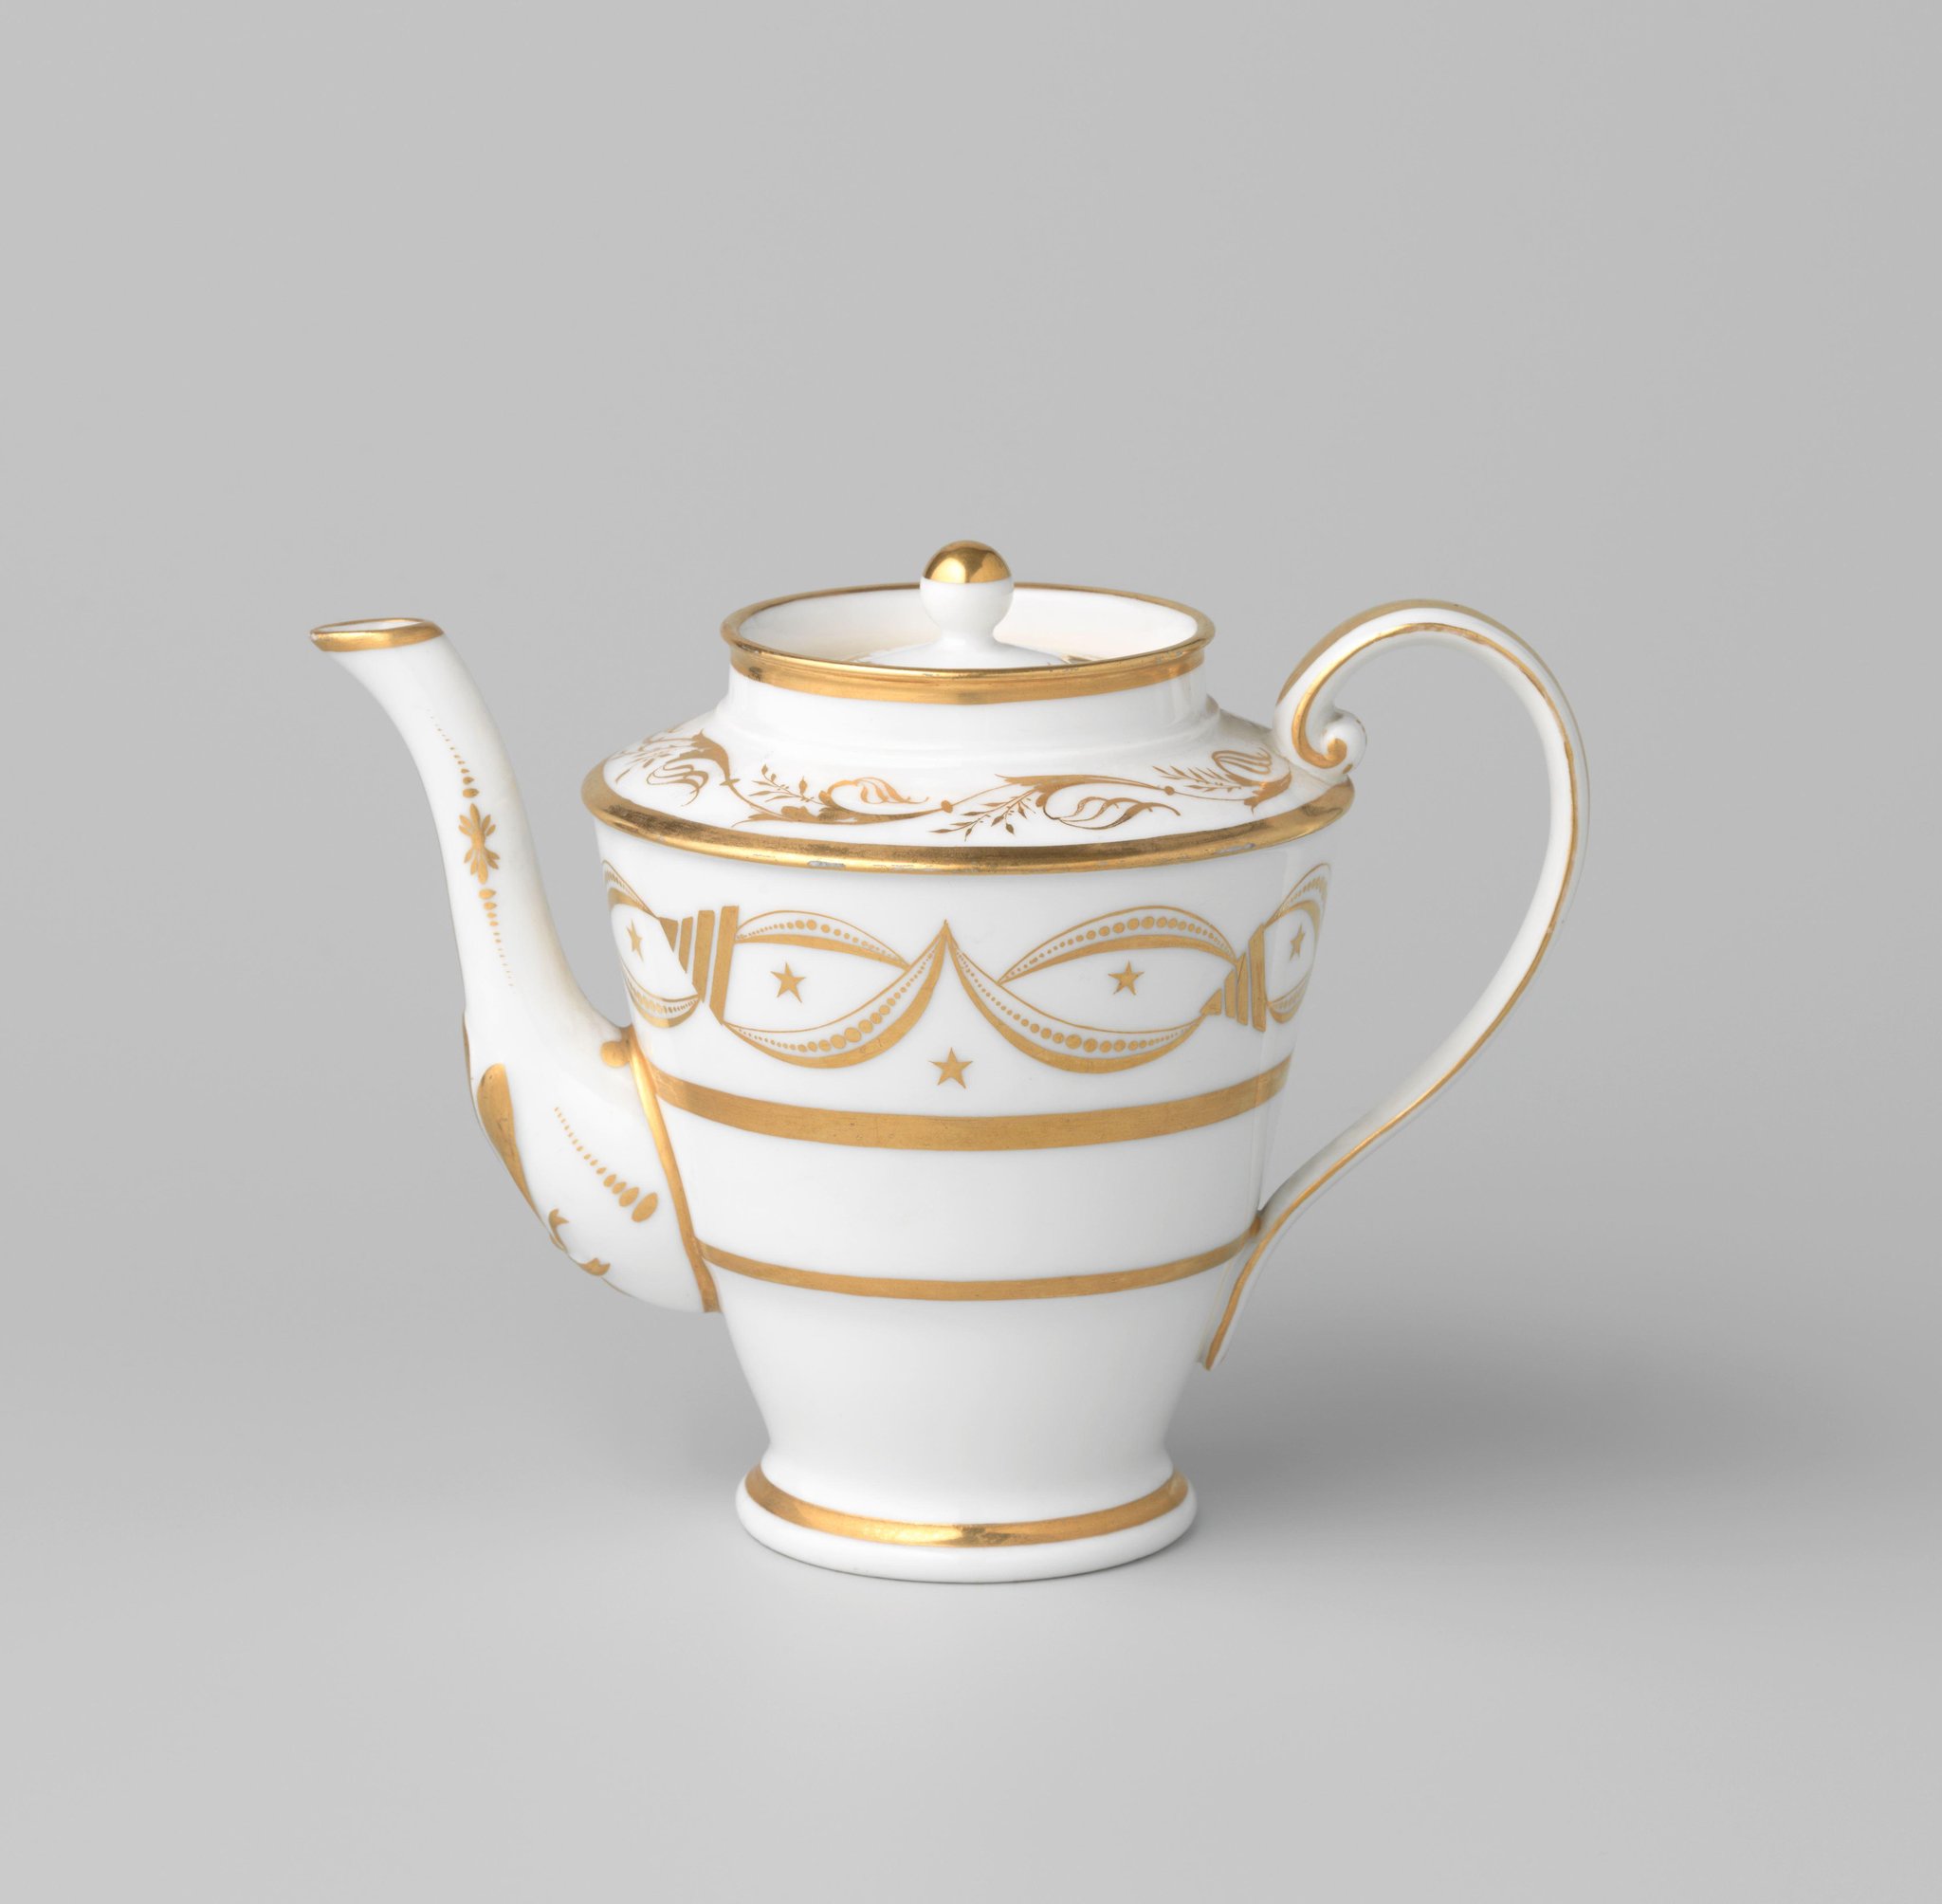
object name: teapot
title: Teapot with stylized flower sprays and ornamental borders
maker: Anonymous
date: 1800-1824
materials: glaze, gold, paint, porcelain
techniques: firing, forming, gilding, turning, vitrification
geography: france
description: Theepot van porselein, beschilderd op het glazuur in goud. De pot heeft een taps toelopende buik op een iets spreidende voet en een korte, wijde nek. Vanuit de buik een S-vormige tuit en een C-vormig oor. De buik is met gouden lijnen verdeeld in drie brede banden met in de bovenste een slinger van sterren, halve maanvormen met stippen en driehoeken. Op de schouder bloemranken. De tuit met een gemodelleerde bloem, gouden lijnen en gestileerde bloemen. De deksel met een band bloemranken. Empire.